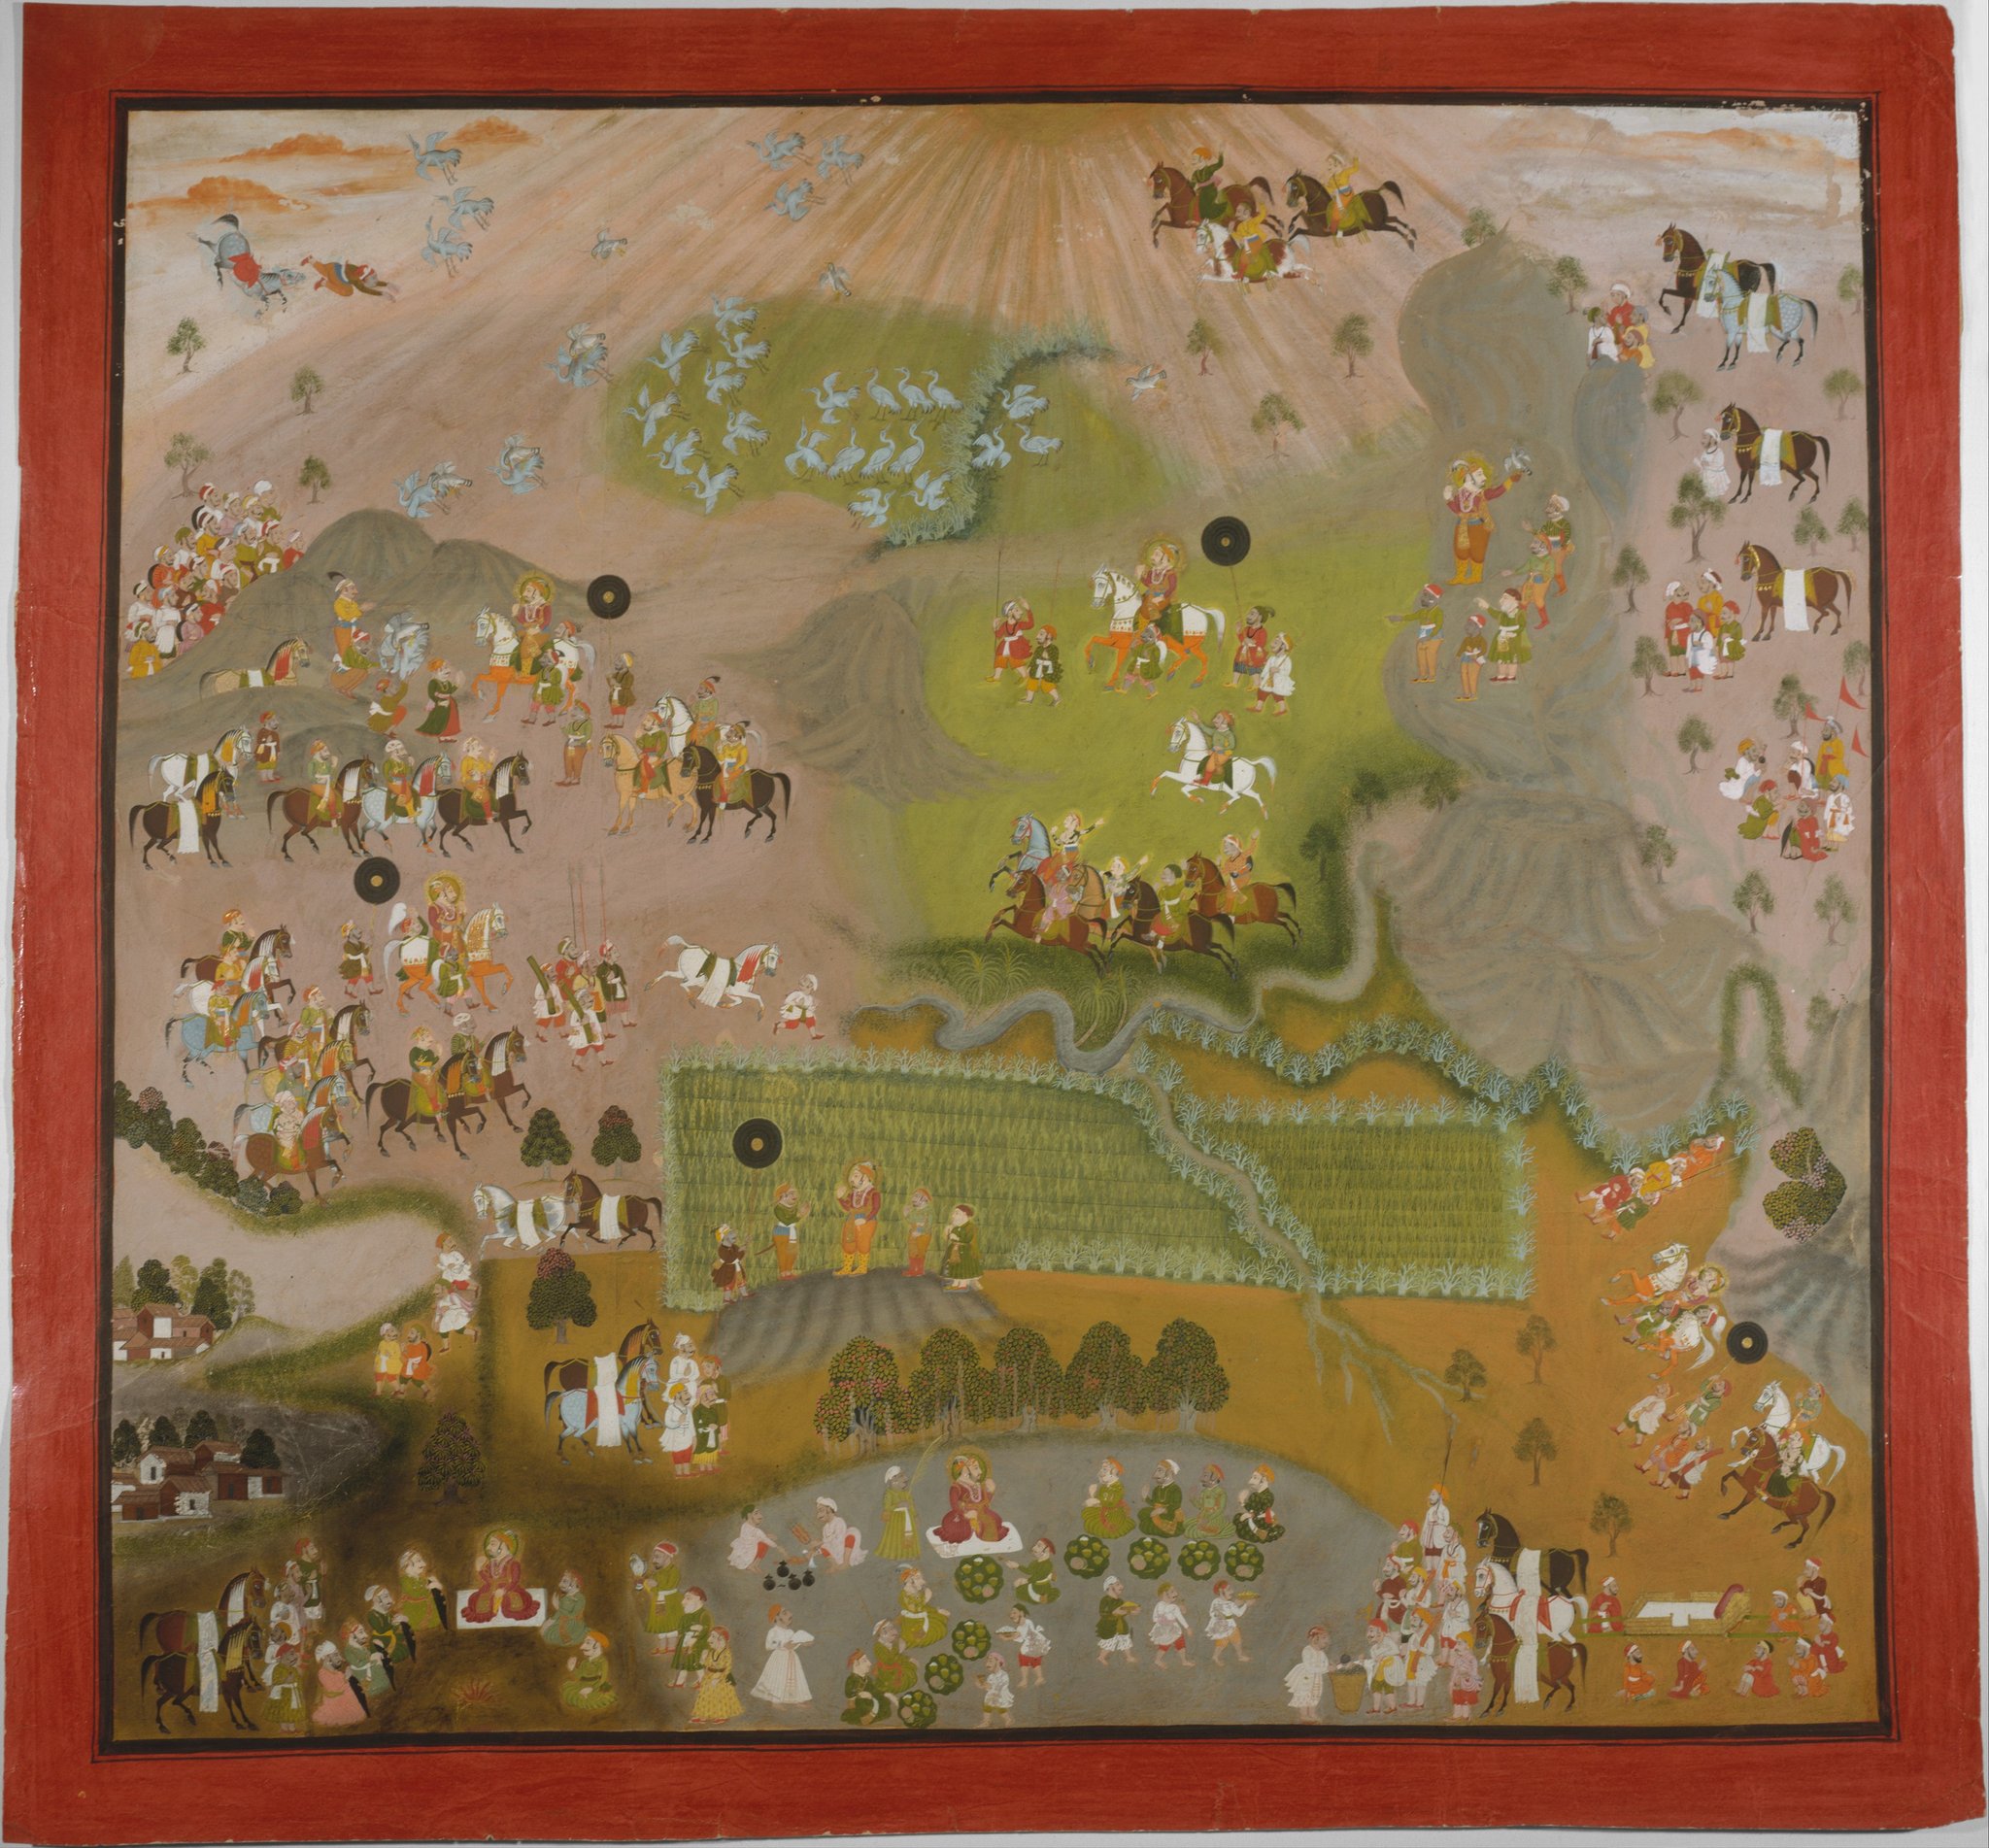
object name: painting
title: Maharana Jagat Singh Hawks for Cranes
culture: western indian, rajasthan, udaipur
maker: shiva and dayal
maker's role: artist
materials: gold, ink, paper, watercolor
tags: cranes,hunting,horses,landscapes